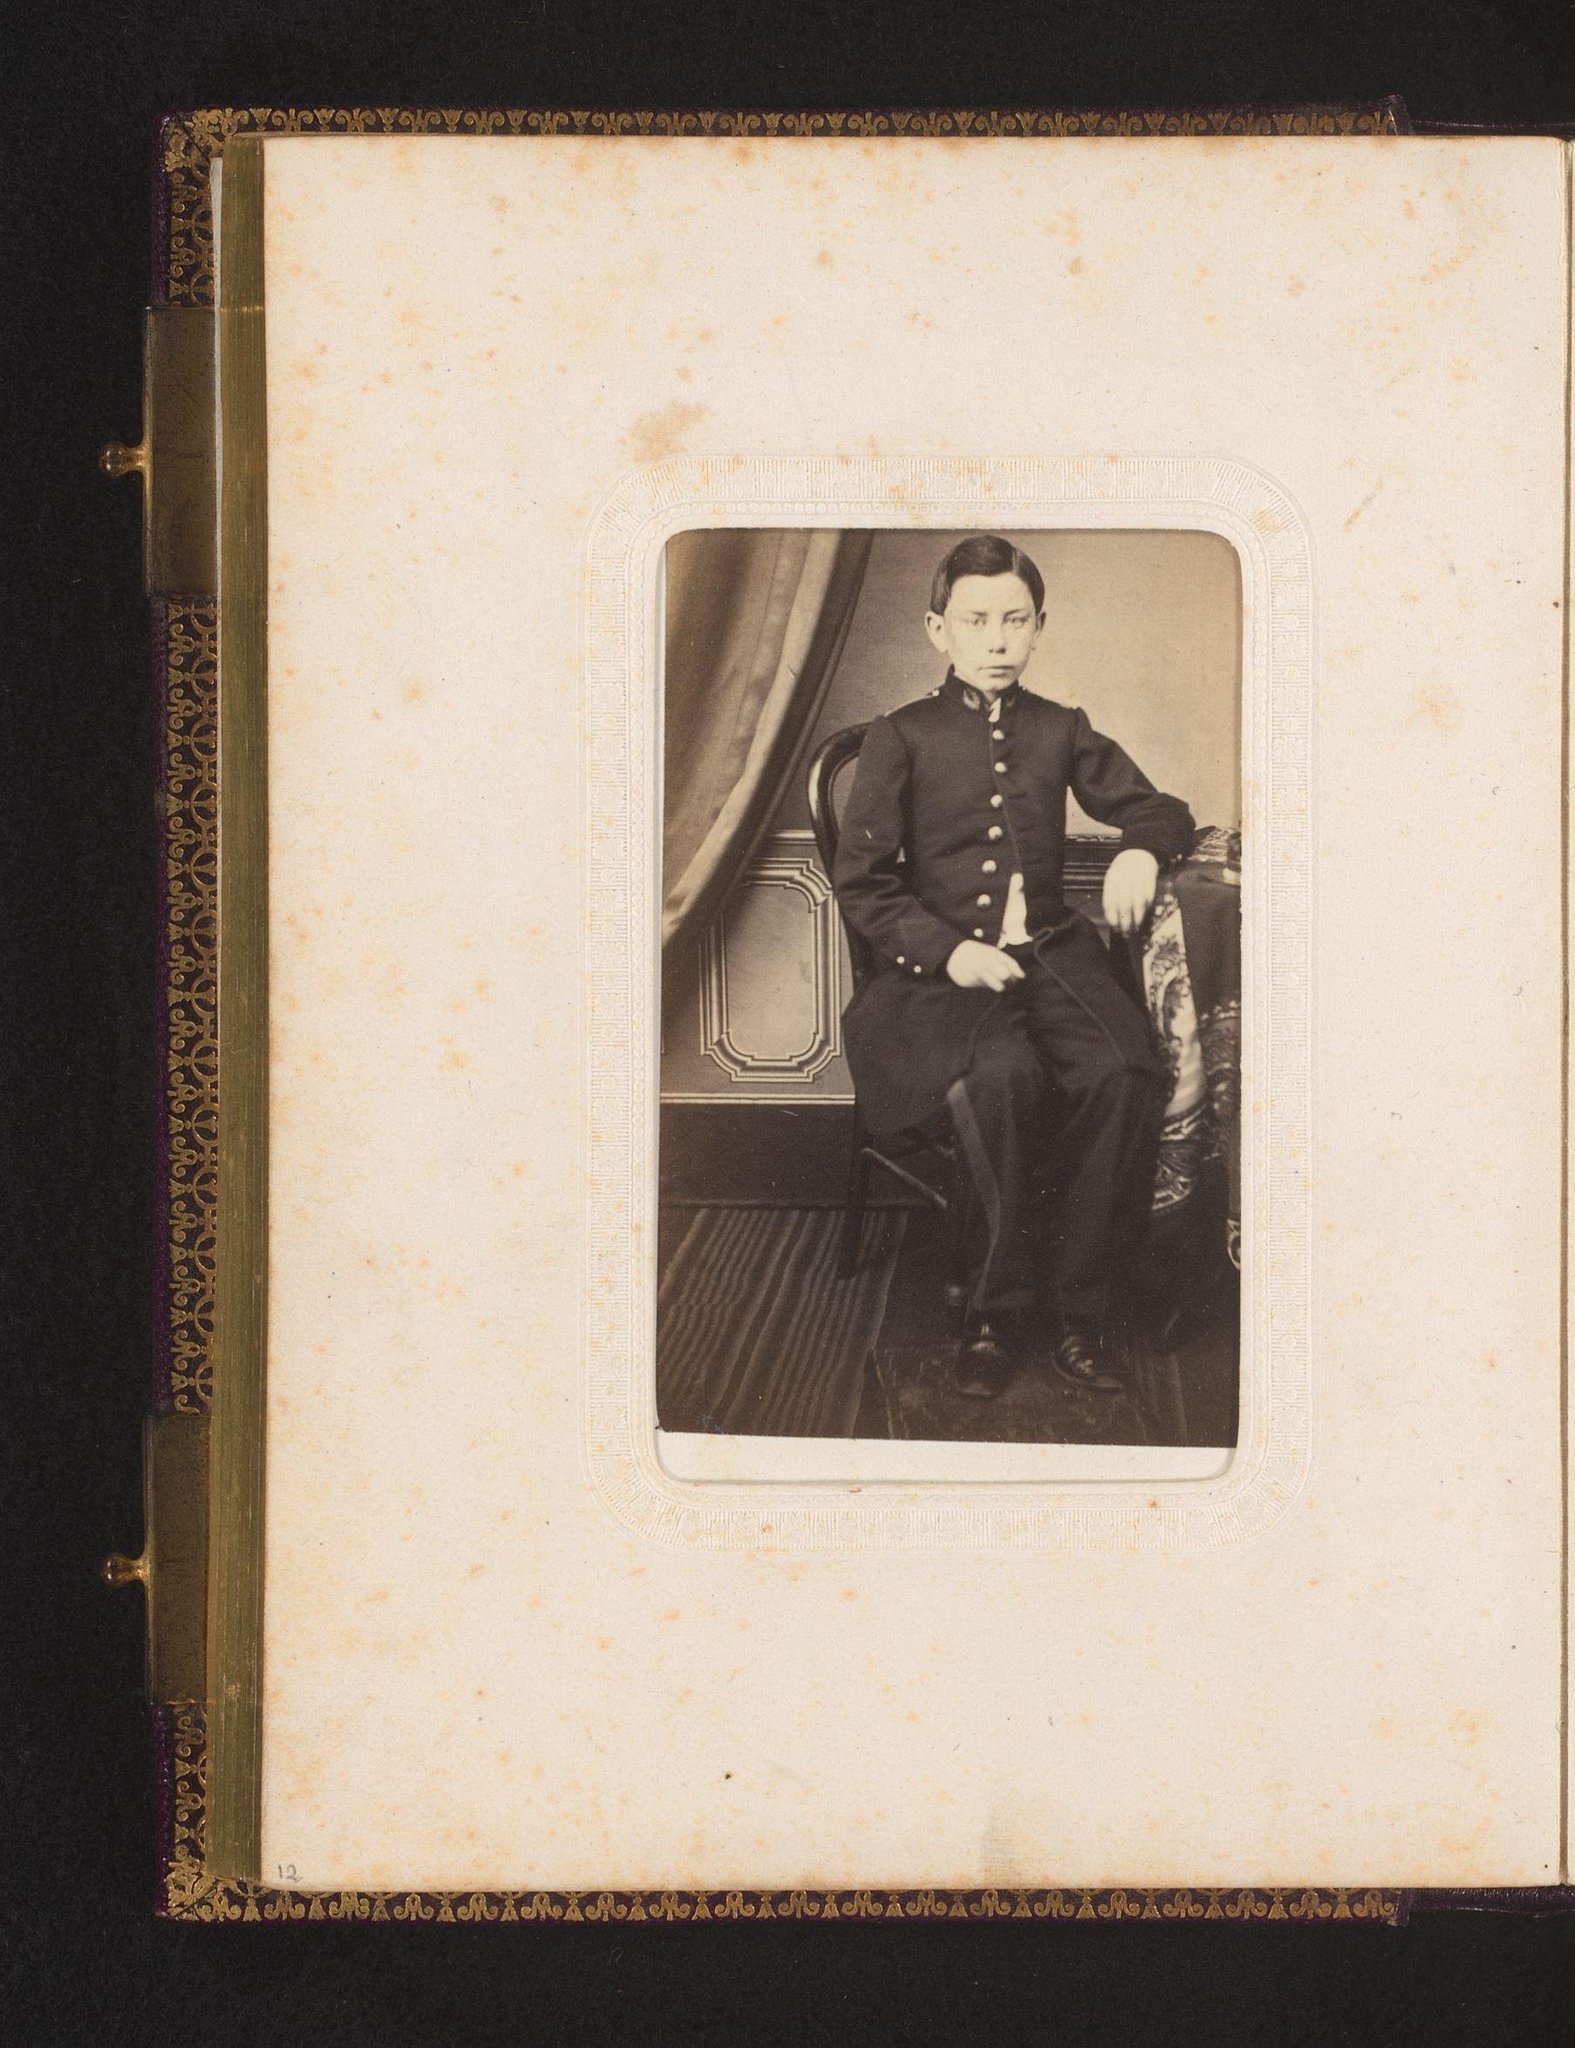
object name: album leaf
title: Portret van een zittende jongen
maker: Anonymous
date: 1860-1900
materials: cardboard, photographic support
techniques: albumen print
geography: france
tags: sitting figure, historical persons, girl (child between toddler and youth)